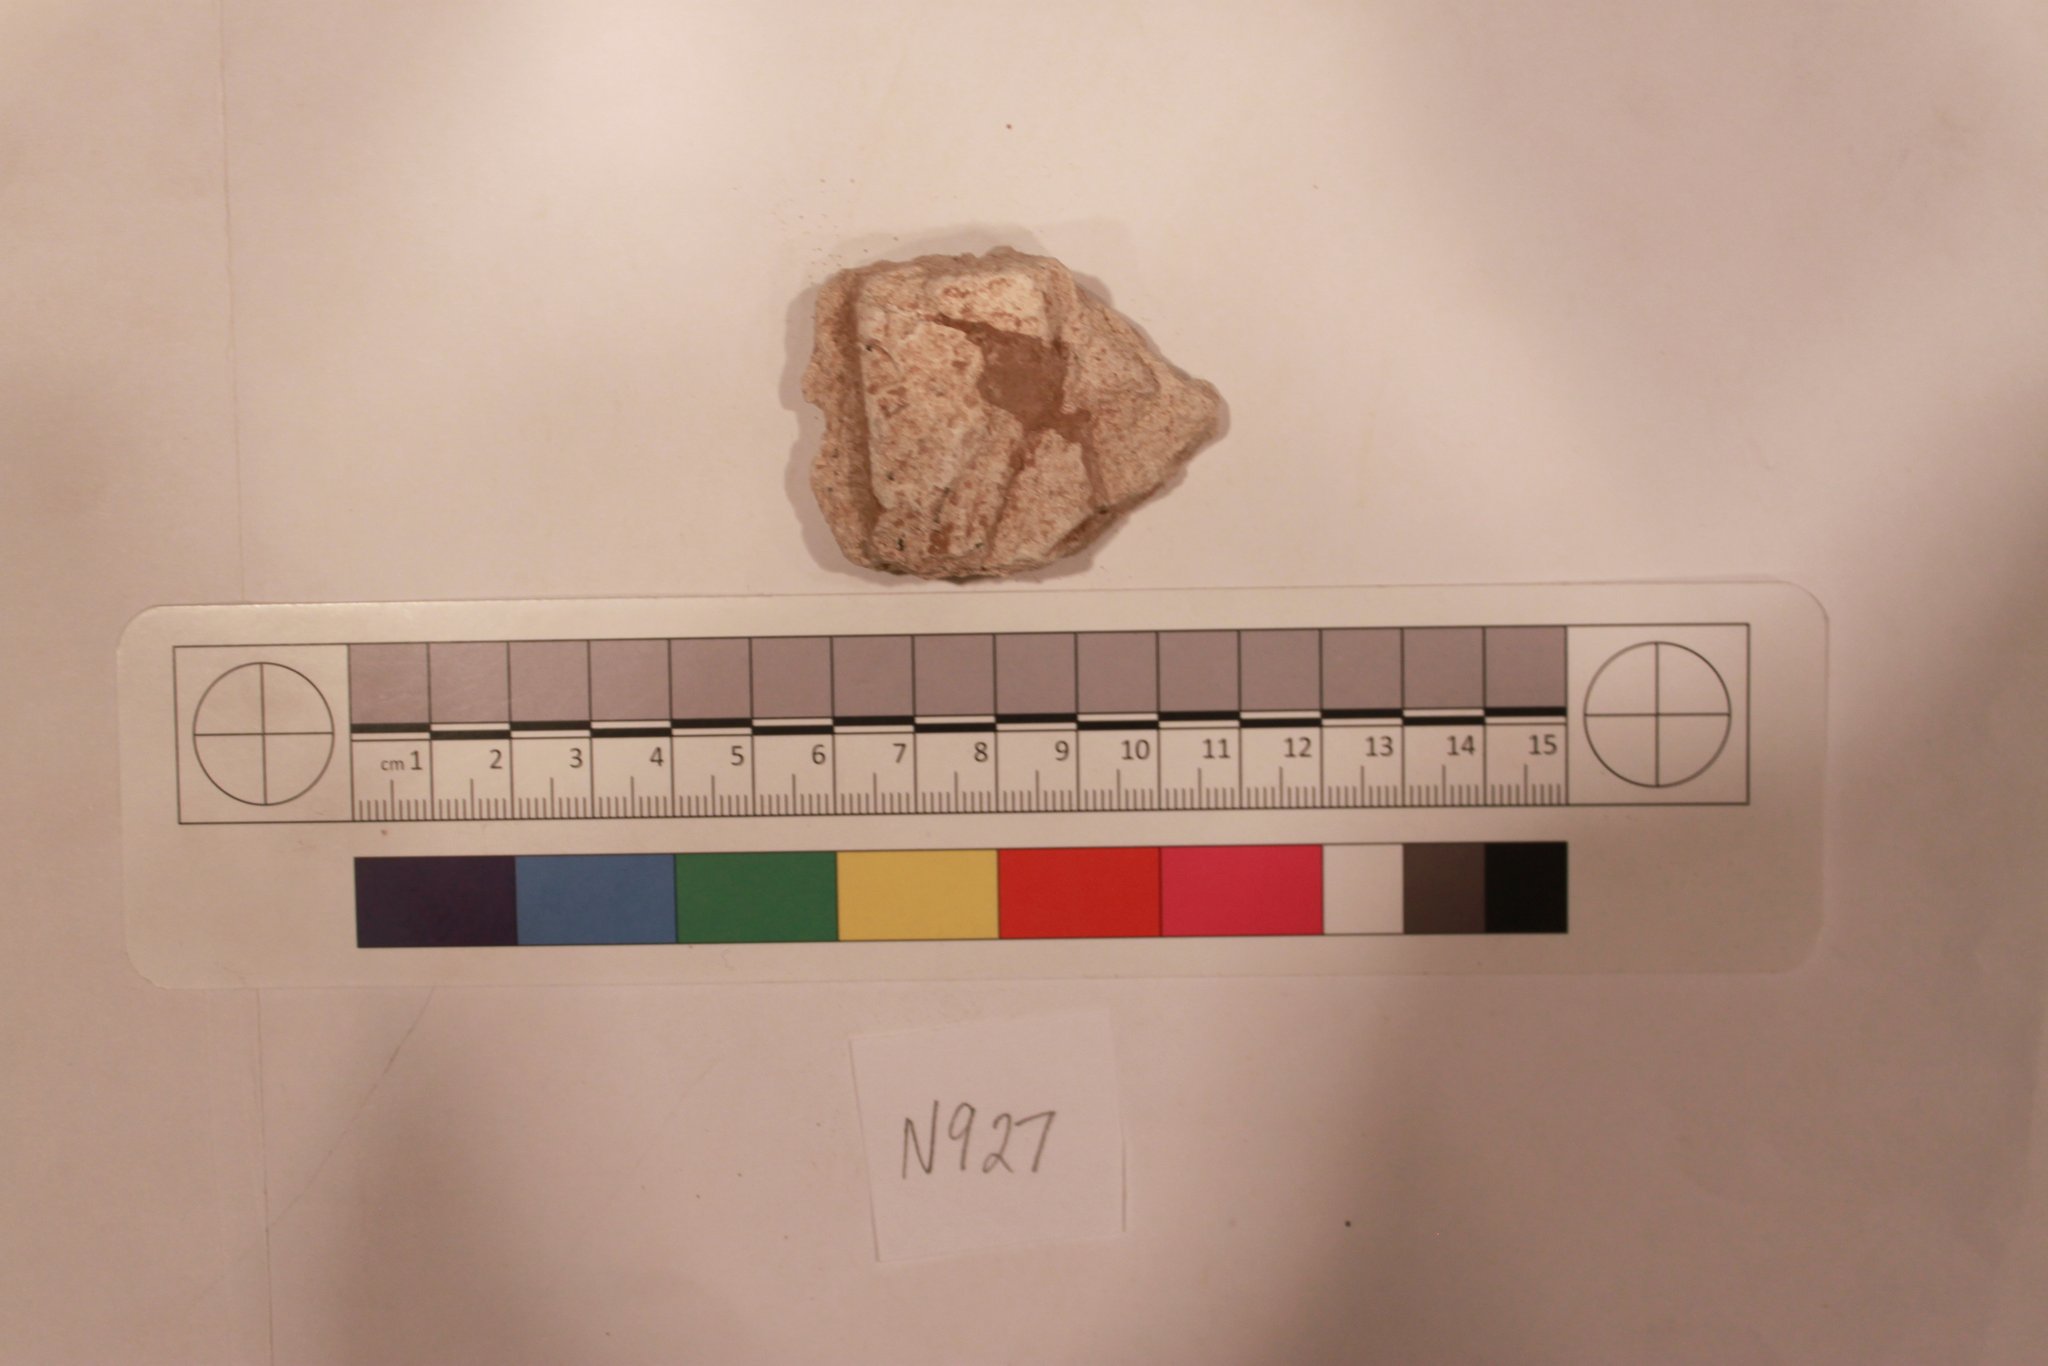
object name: fragment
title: Stucco Fragment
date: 701-1200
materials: plaster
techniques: carving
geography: iran